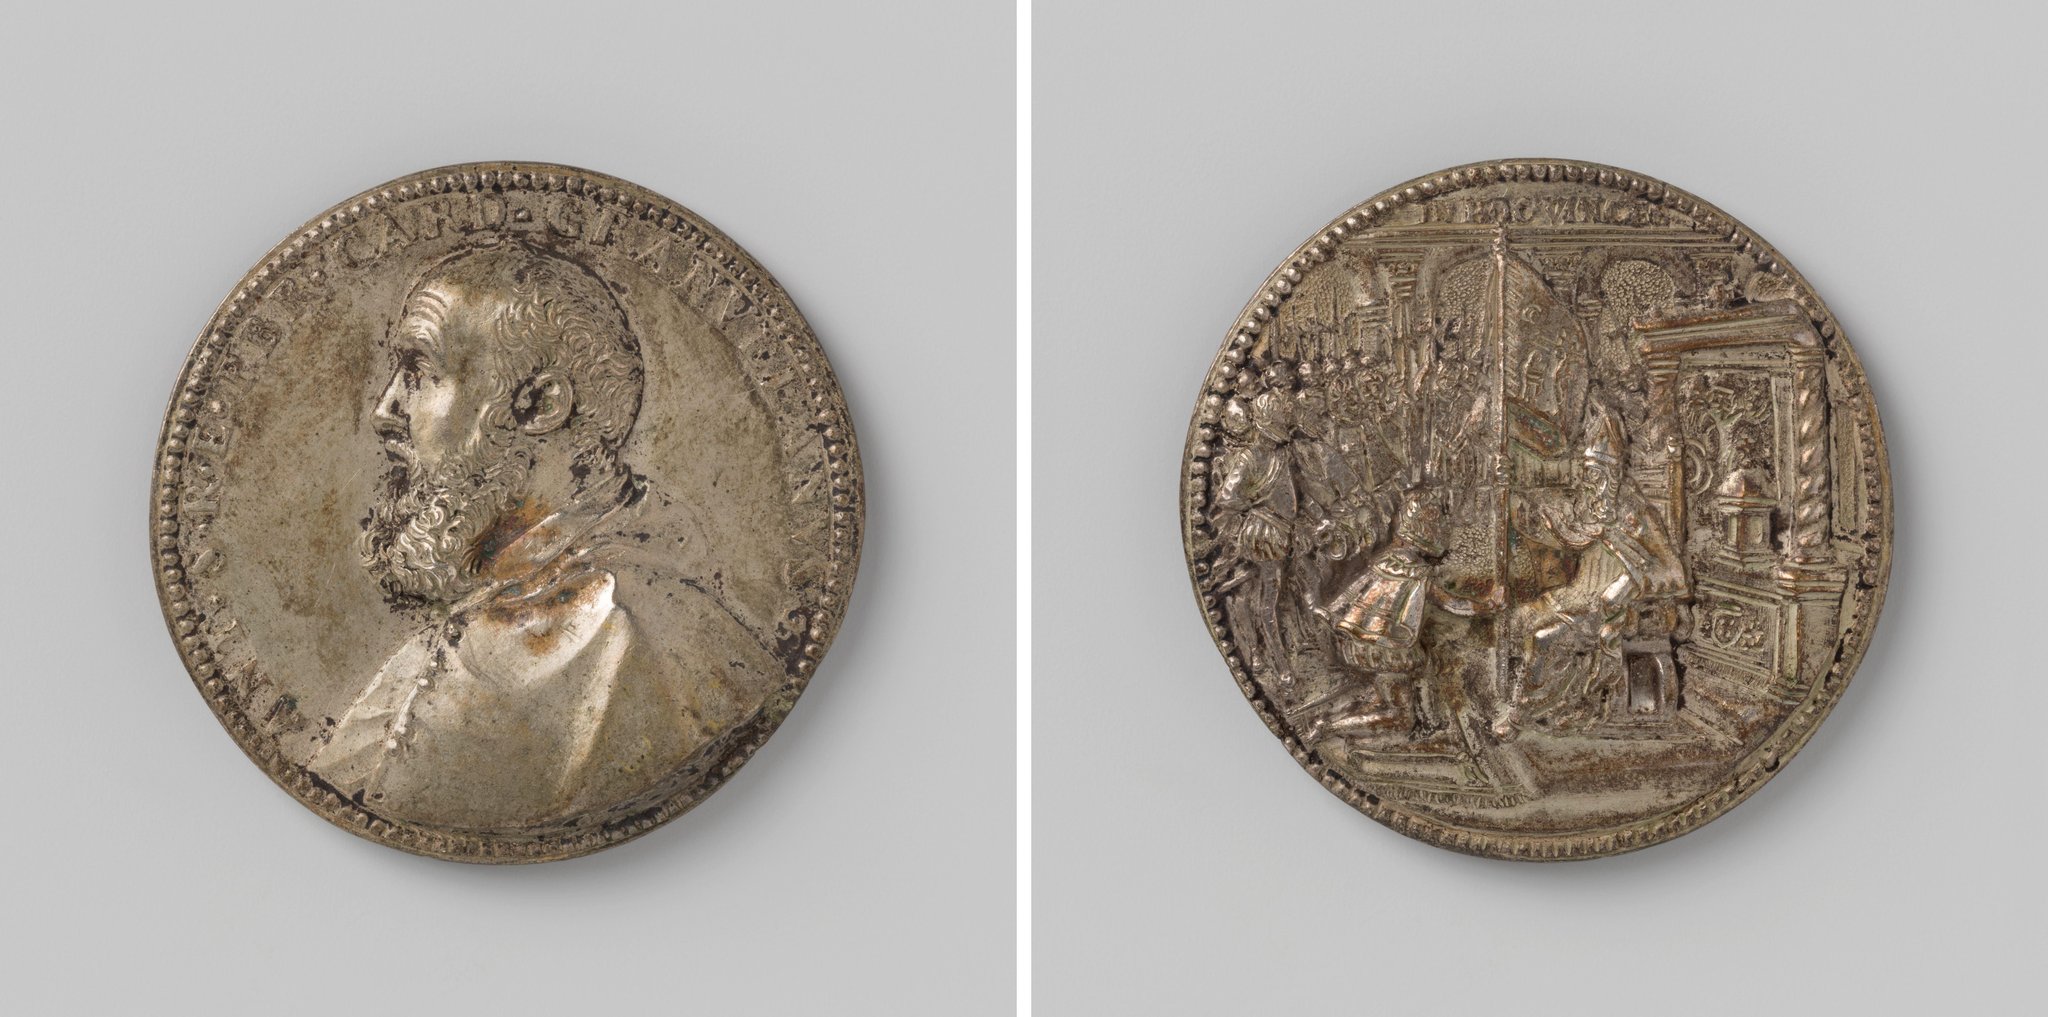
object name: history medal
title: Kardinaal Granvelle overhandigt de gewijde standaard aan don Juan van Oostenrijk voor de oorlog tegen de Turken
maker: giovanni v. melon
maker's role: medailleur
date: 1571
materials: silver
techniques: casting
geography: rome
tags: antoine perrenot de granvelle, don juan van oostenrijk, naples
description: Zilveren penning. Voorzijde: borststuk man binnen omschrift. Keerzijde: Granvelle zit in bisschopplijk gewaad op een troon voor een altaar en overhandigt in aanwezigheid van verschillende edelen standaard aan don Juan, die voor hem op kussen knielt onder opschrft.